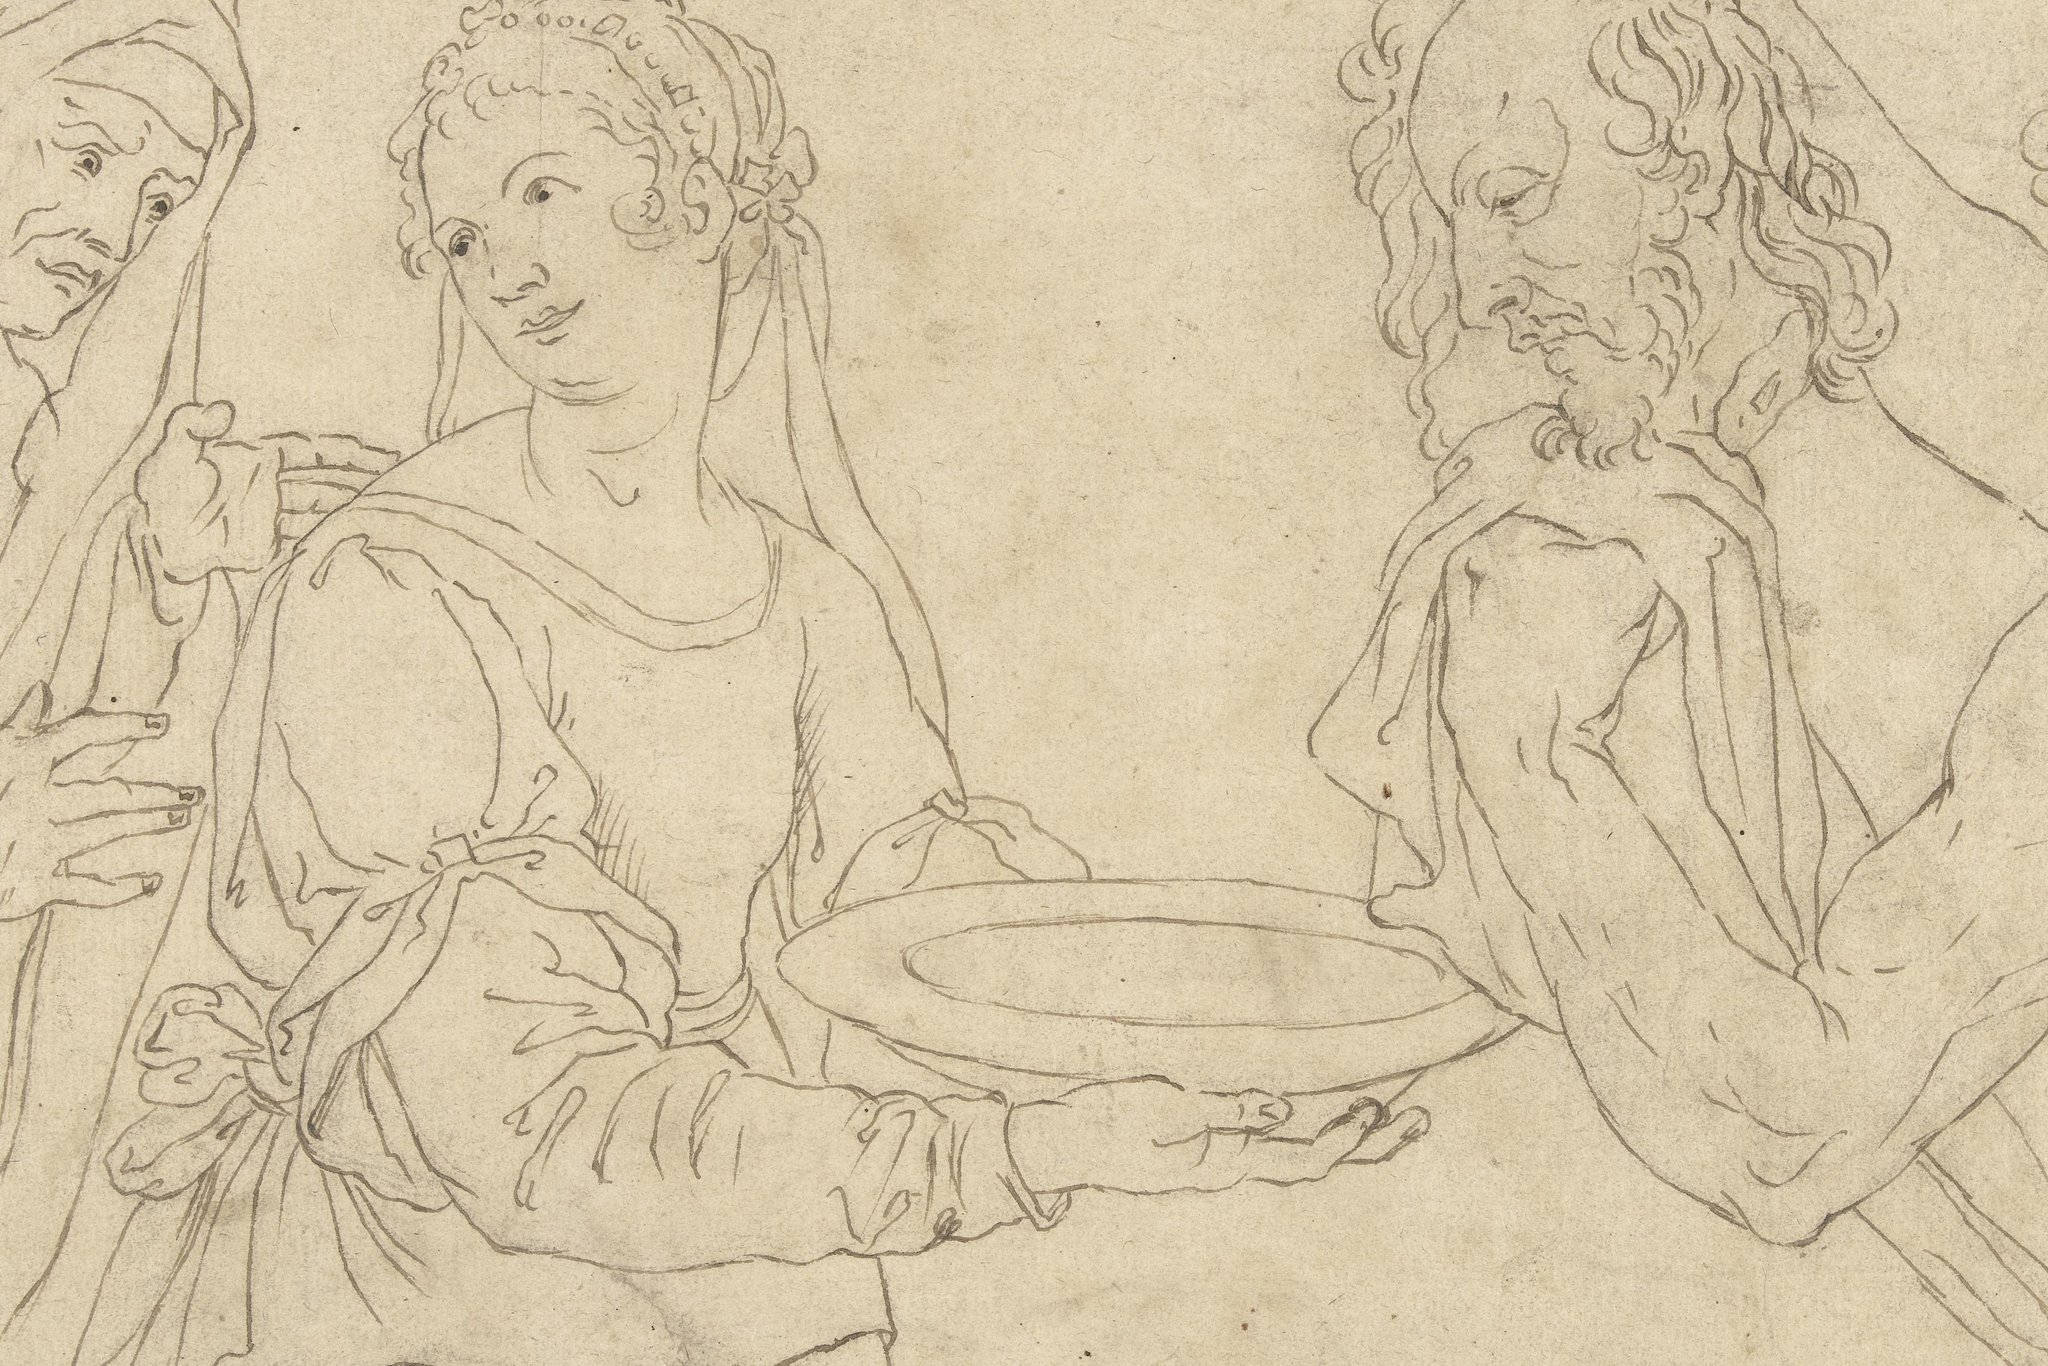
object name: drawing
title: Salome ontvangt het hoofd van Johannes de Doper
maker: Anonymous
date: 1600-1699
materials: ink, paper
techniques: pen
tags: salome is given the head of john the baptist by the executioner